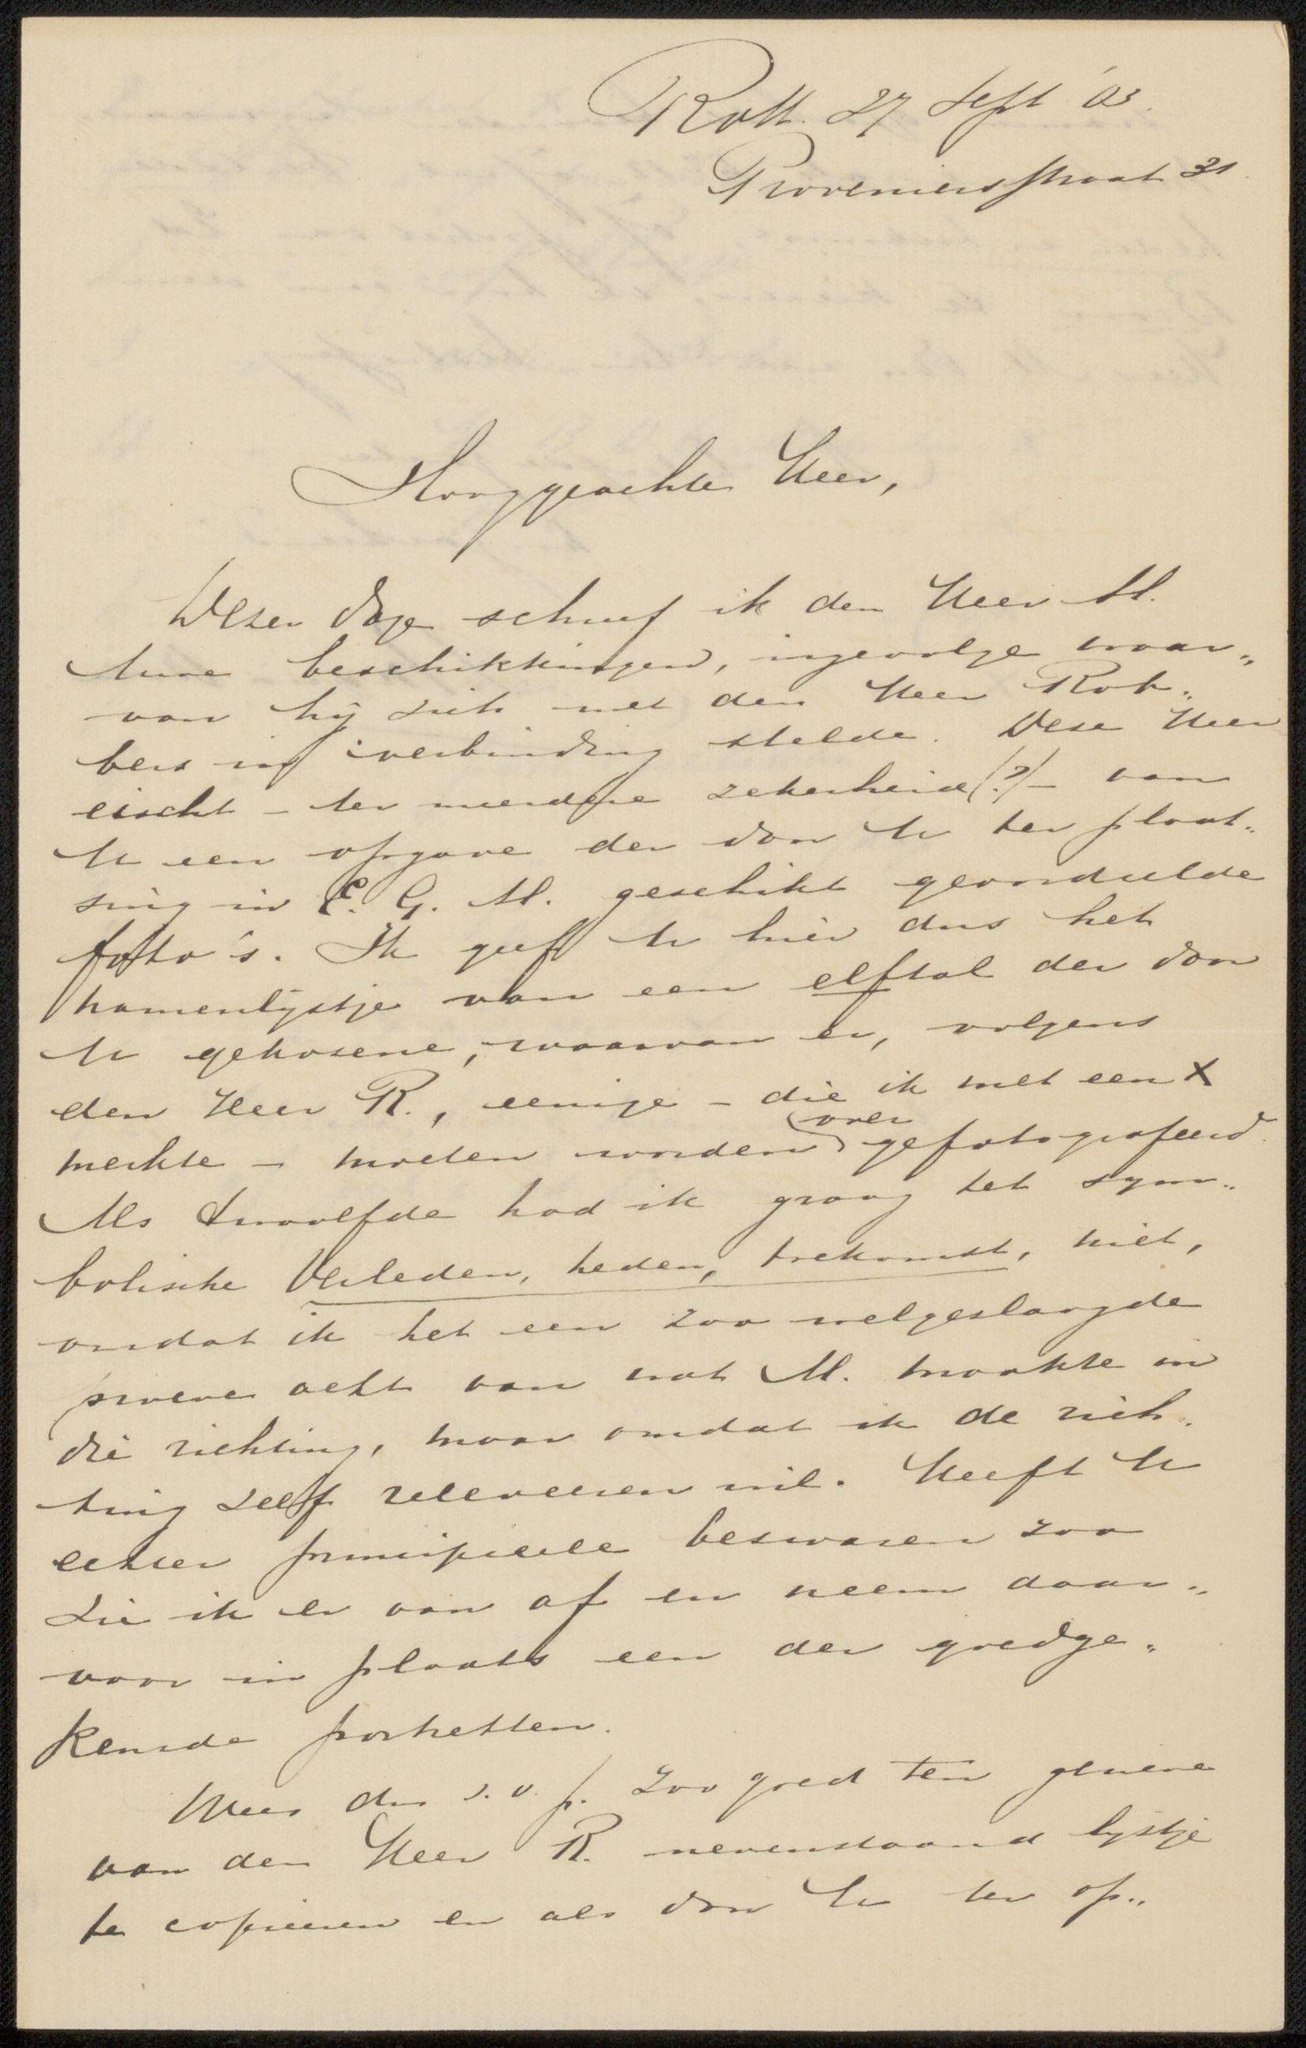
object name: letter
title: Brief aan Philip Zilcken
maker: maria viola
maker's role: dichter, kunstcriticus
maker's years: 1871-1951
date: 1903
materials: ink, paper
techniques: pen, writing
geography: rotterdam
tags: haarlem, print maker, anton molkenboer, the hague, draughtsman, philip zilcken, photography, cinematography, historical persons (portraits and scenes from the life)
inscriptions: watermark, collector's mark: ‘RPK’